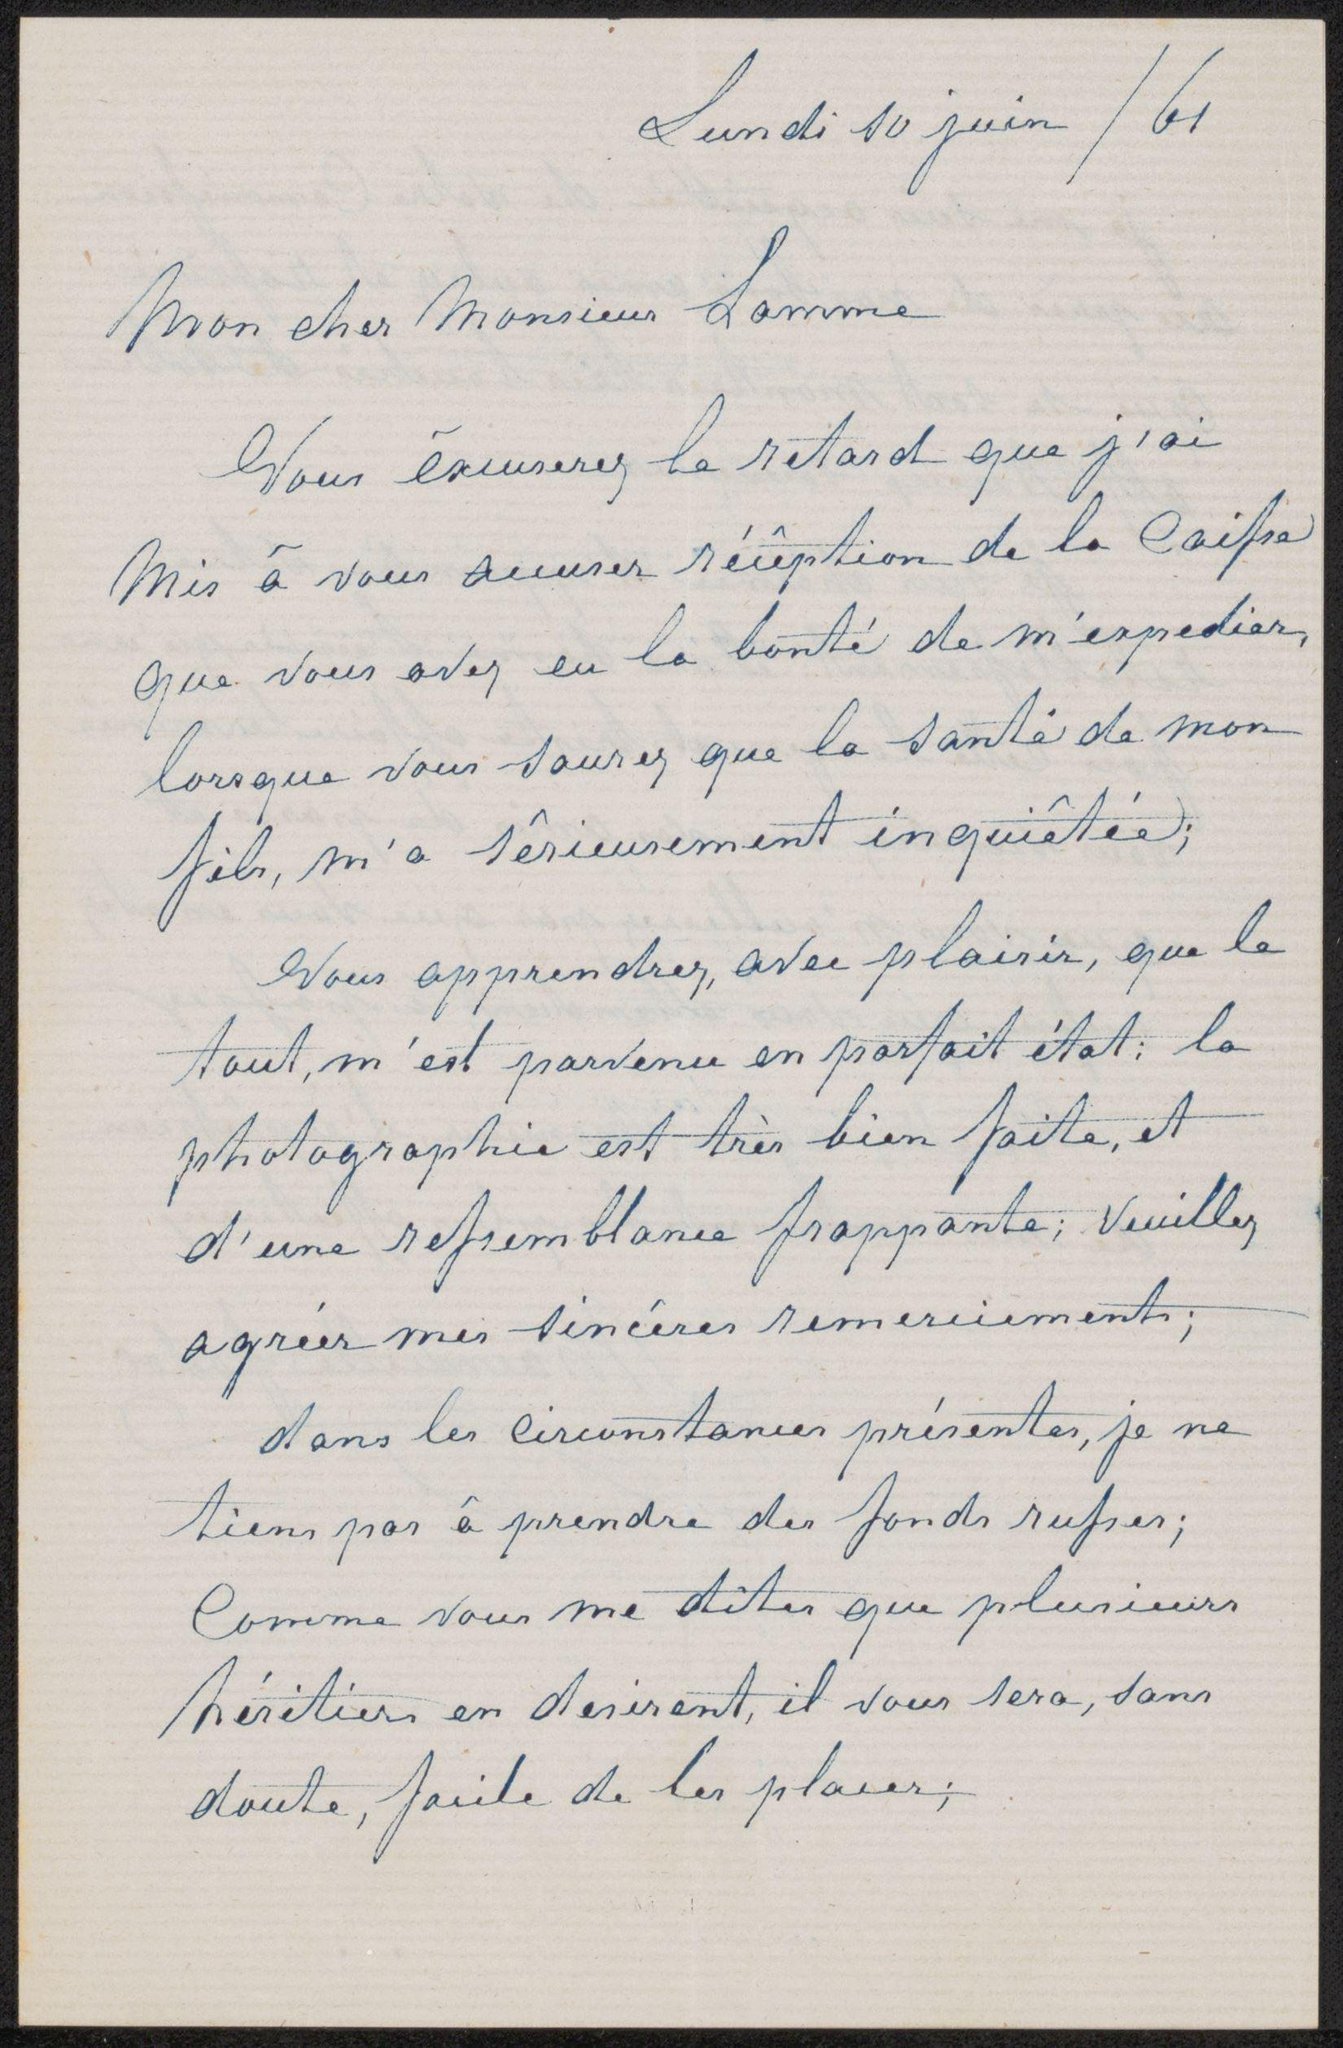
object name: letter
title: Brief aan Ary Johannes Lamme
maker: josephine fodor-mainville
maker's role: zangeres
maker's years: 1789-1870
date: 1861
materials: ink, paper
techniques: pen, writing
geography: passy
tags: dordrecht, print maker, draughtsman, ary johannes lamme, gioacchino antonio rossini, photography, cinematography, family life, diseases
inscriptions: collector's mark: Lugt 2228